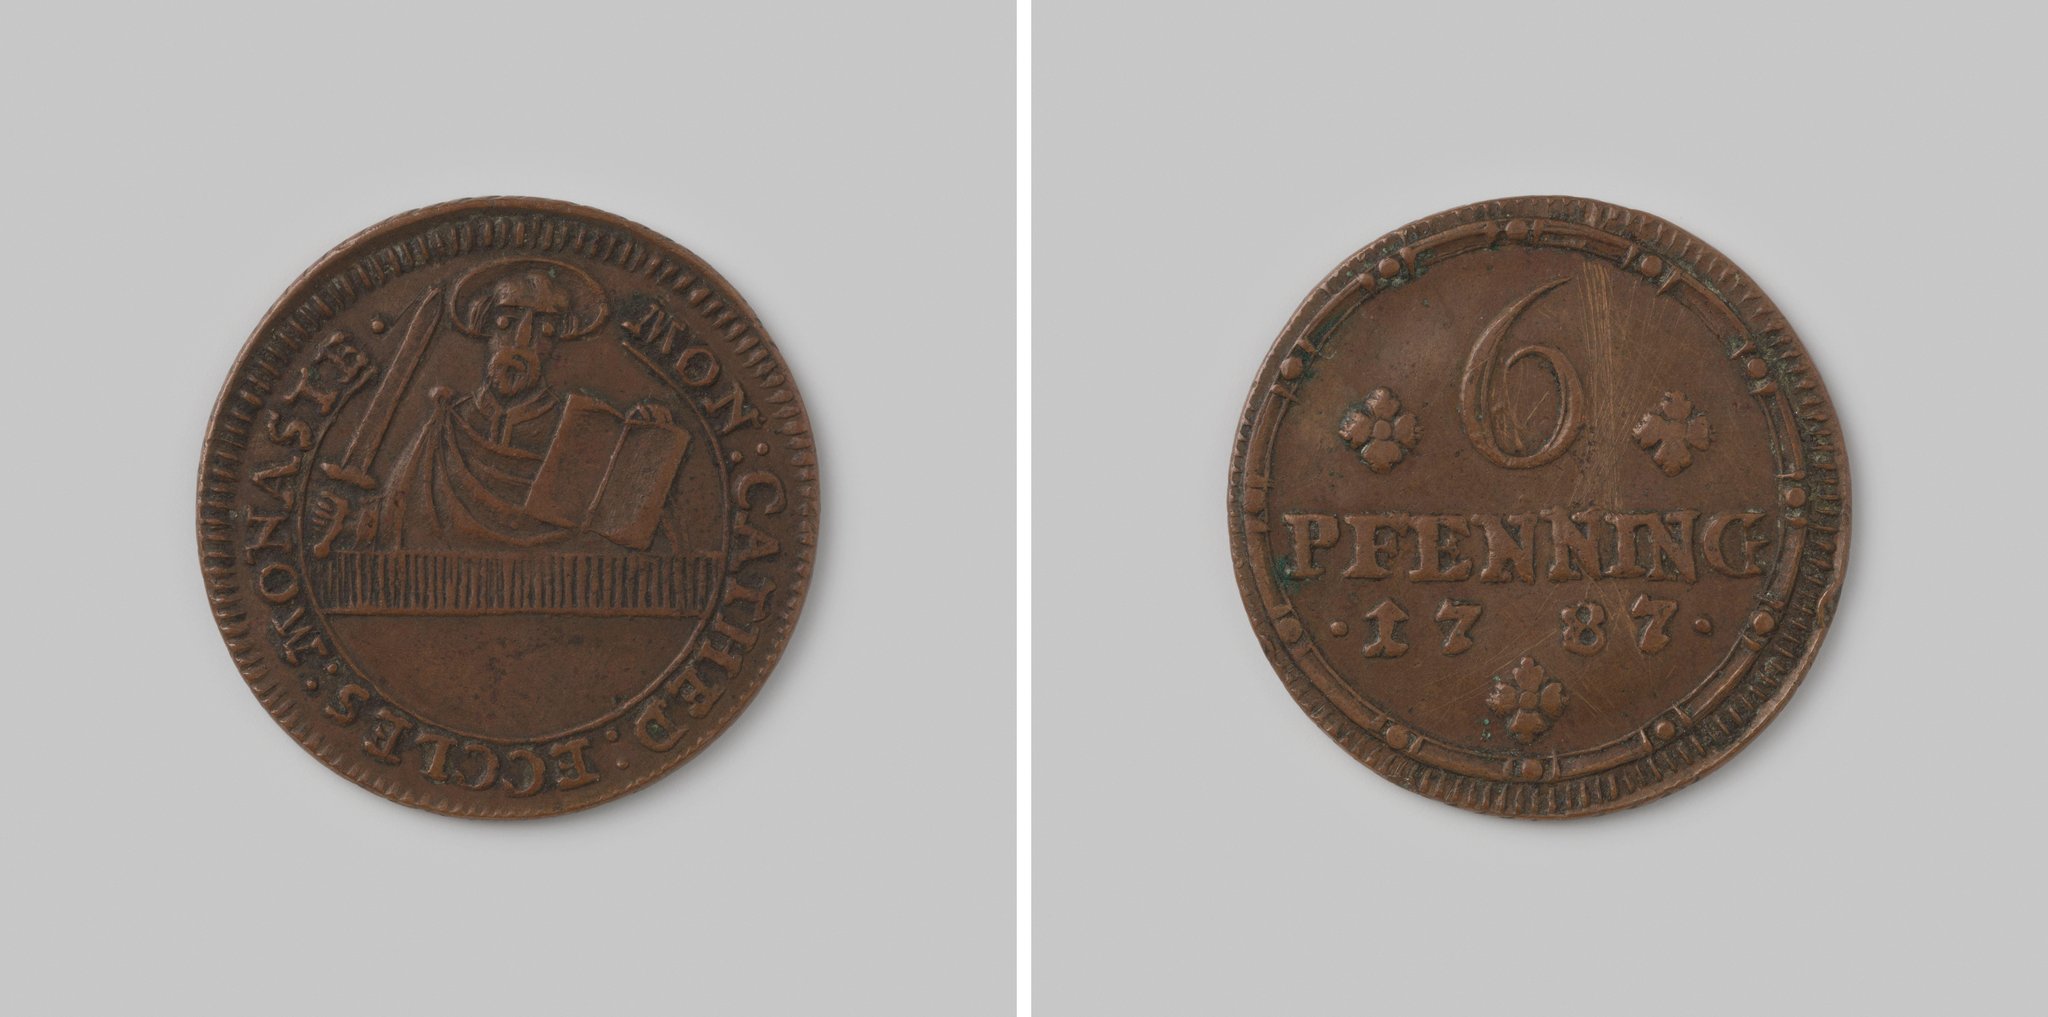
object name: z pfenning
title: zes pfenning uit het domkapittel van Münster, 1787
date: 1787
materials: copper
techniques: striking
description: Koperen munt. Voorzijde: de heilige Paulus met boek en zwaard, zittend aan een tafel. Keerzijde: binnen een cirkelvomige versiering waarde-aanduiding in twee regels, waaronder jaartal. Kabelrand.